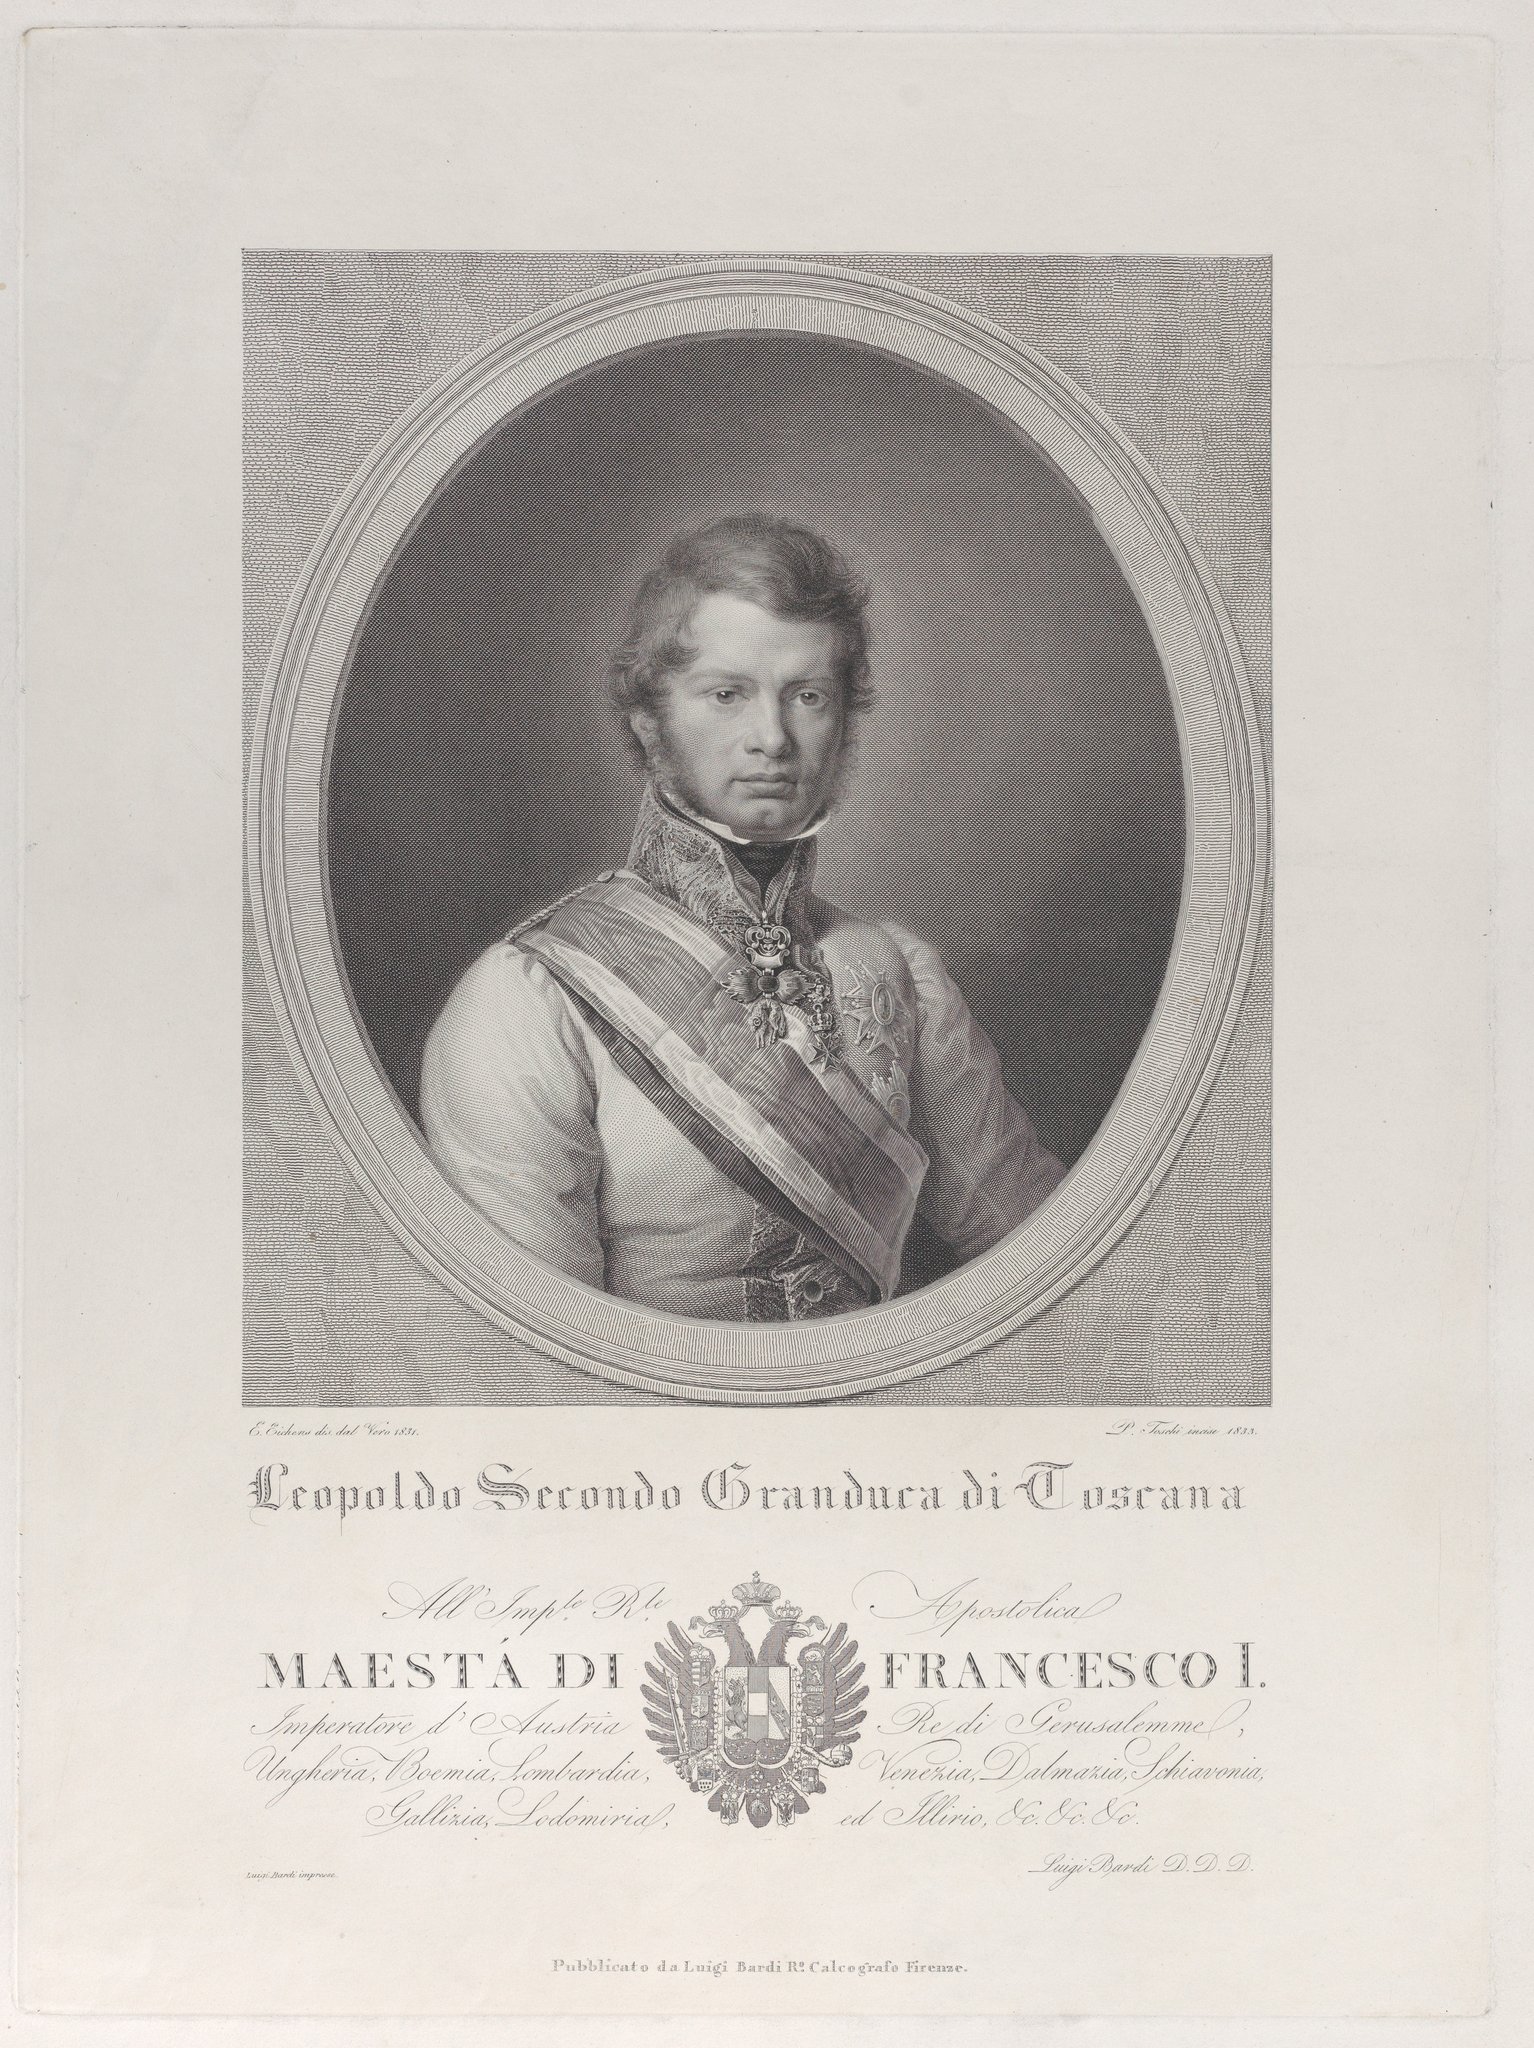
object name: print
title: Oval portrait of Leopold II, Grand Duke of Tuscany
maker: paolo toschi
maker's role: artist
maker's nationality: italian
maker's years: 1788-1854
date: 1833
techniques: engraving, etching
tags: men,portraits